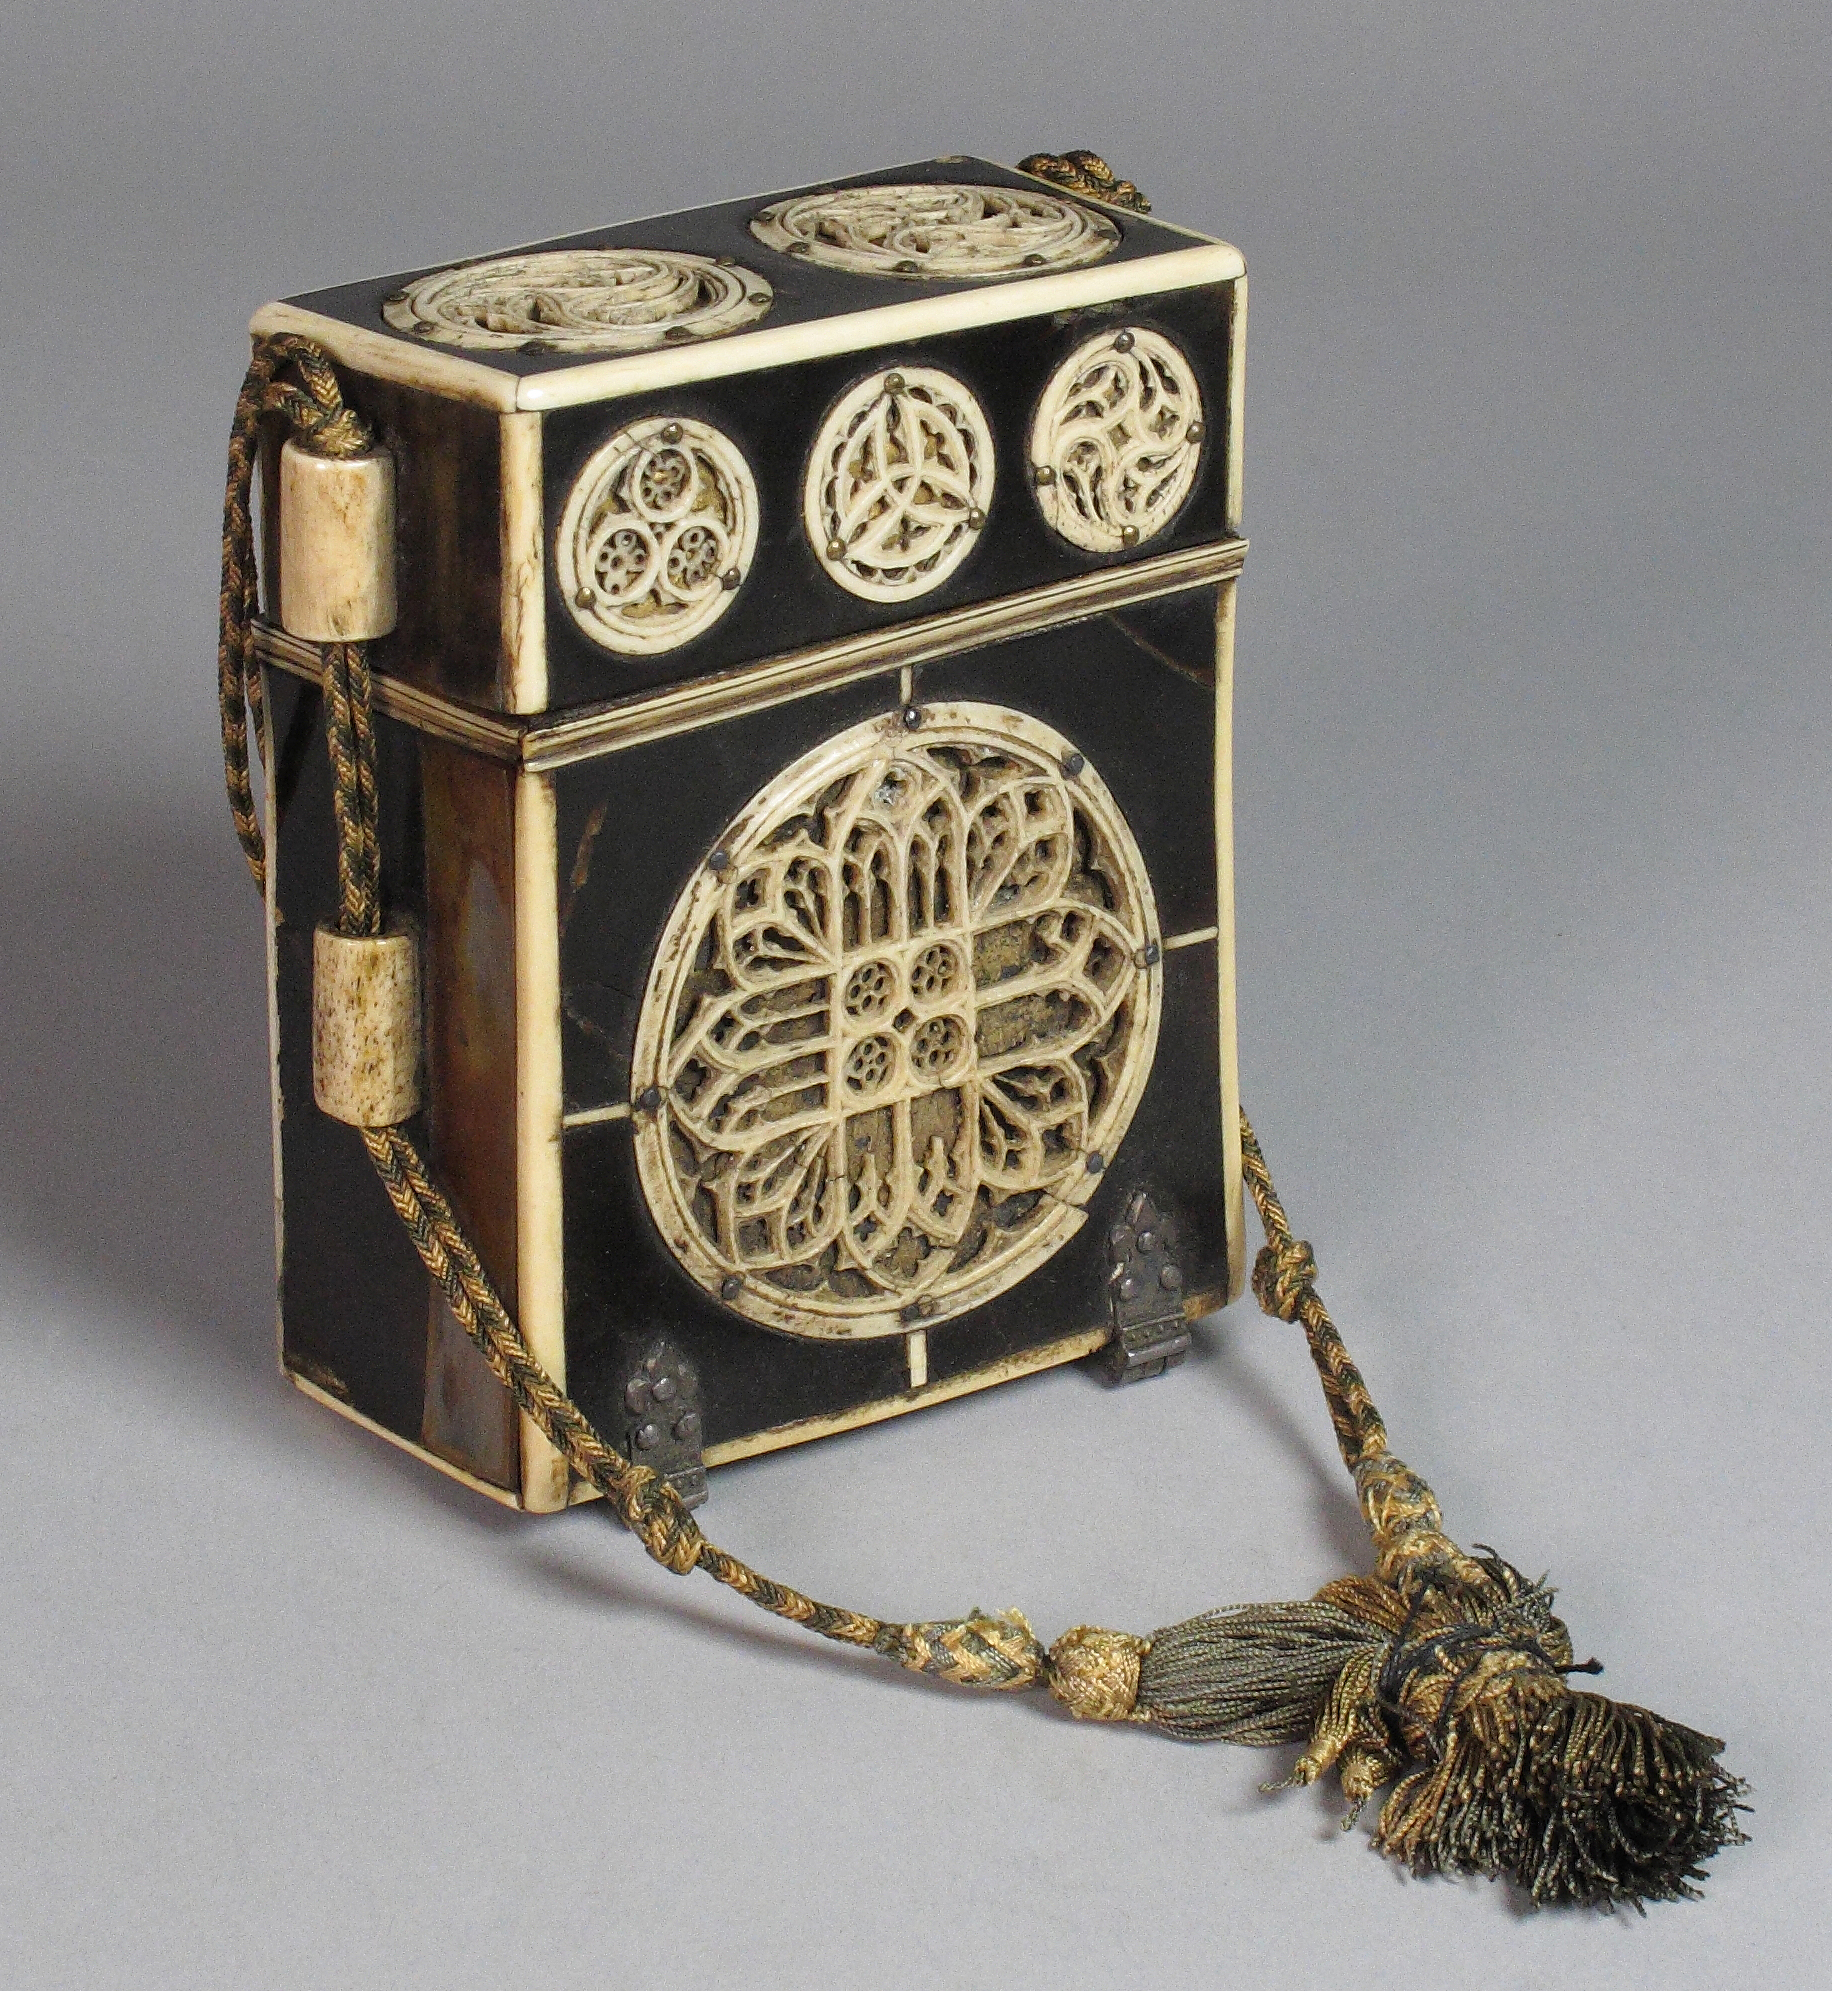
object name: manuscript case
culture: european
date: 1801-1900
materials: bone, horn, silk